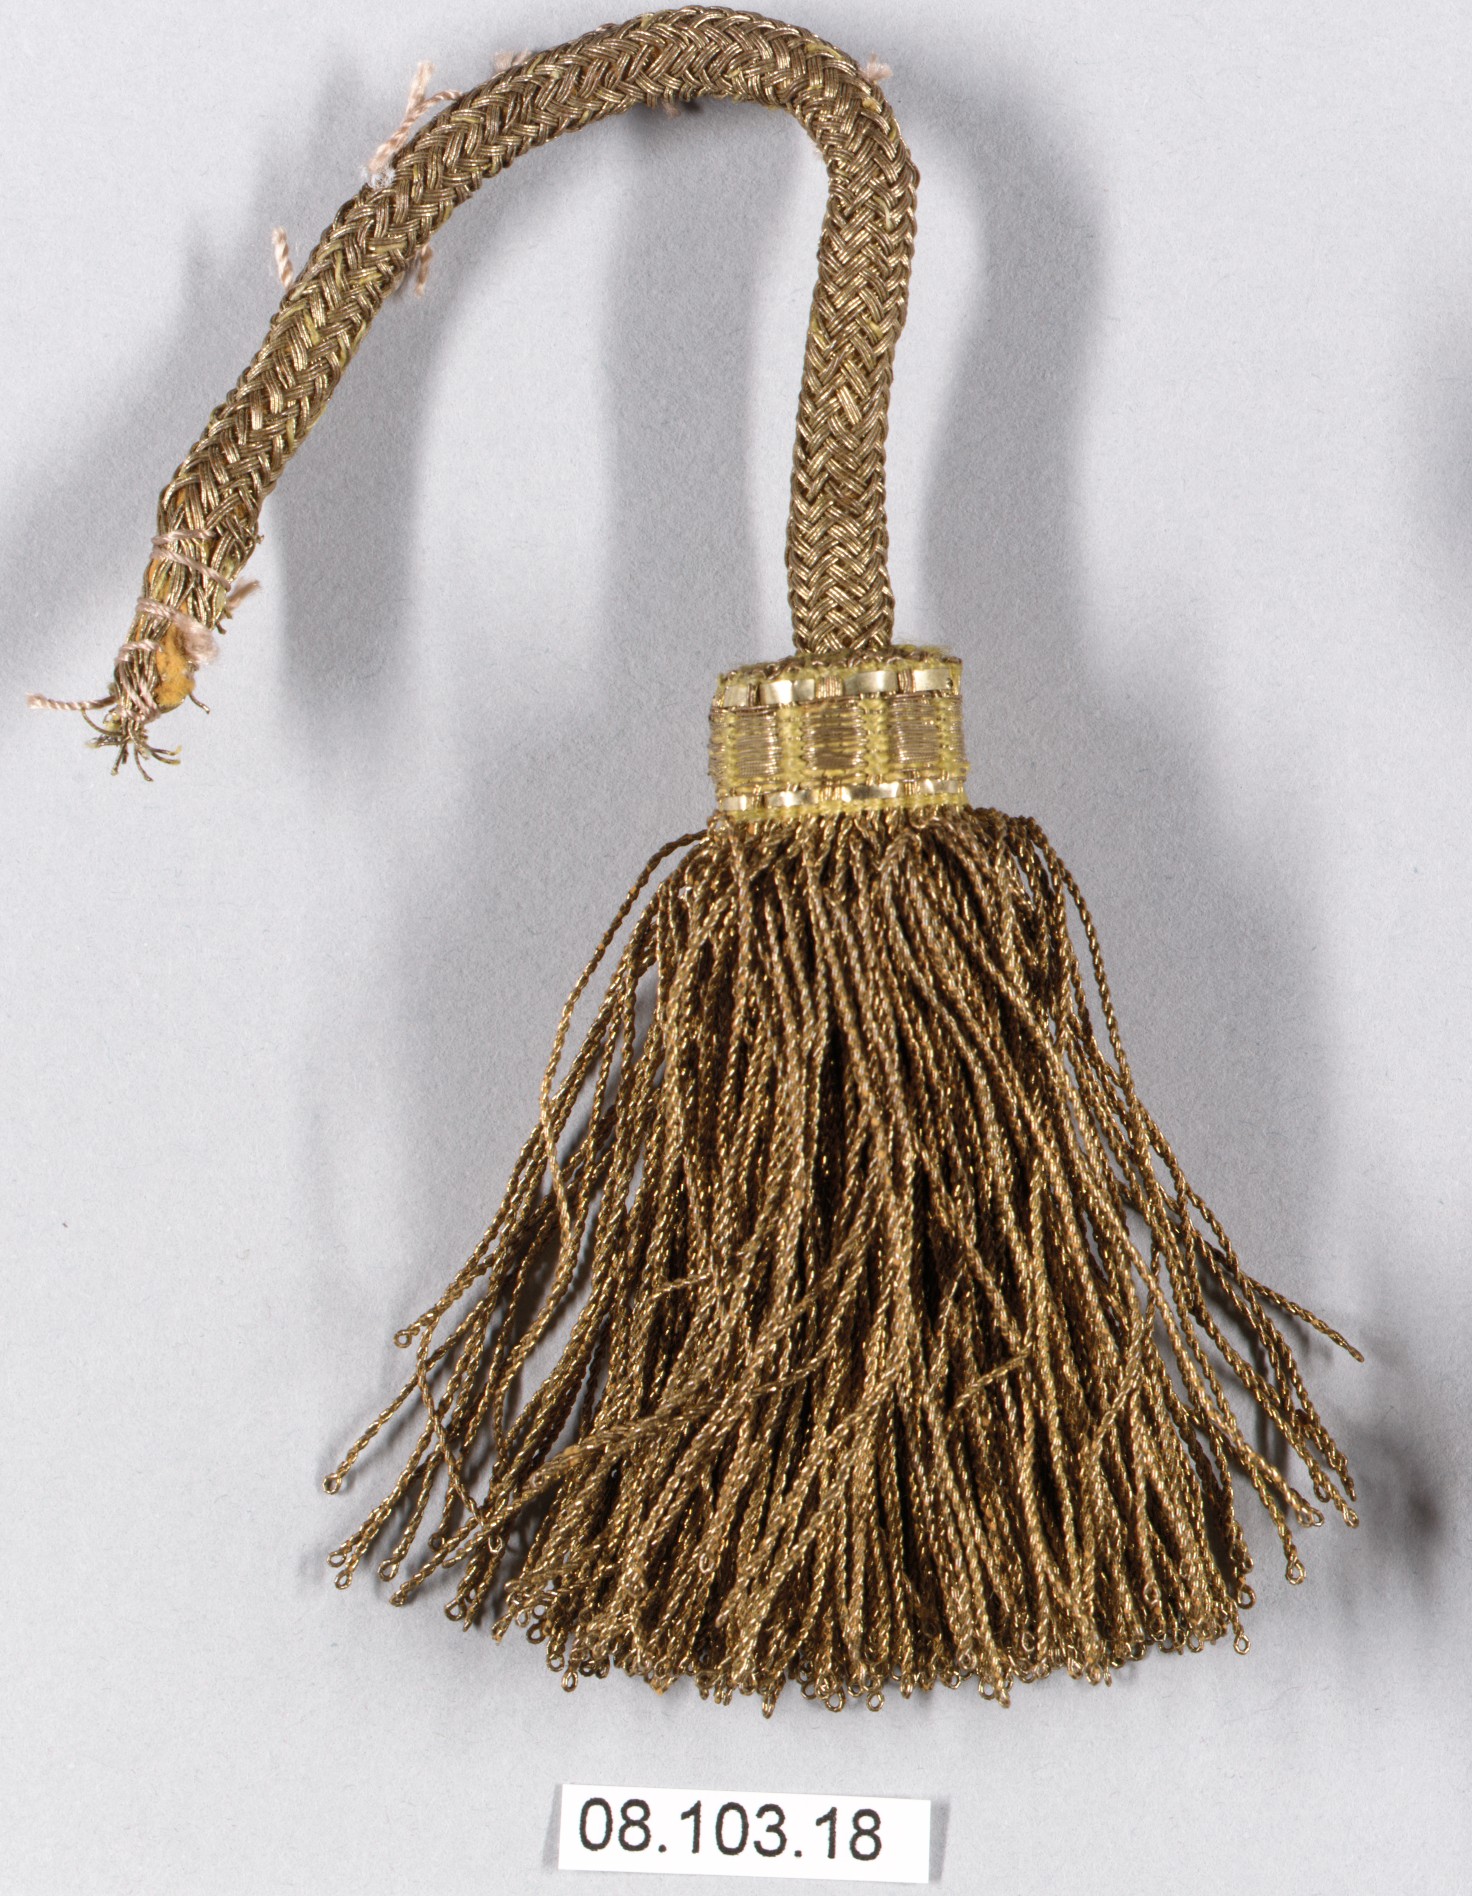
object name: tassel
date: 1601-1700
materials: metal thread